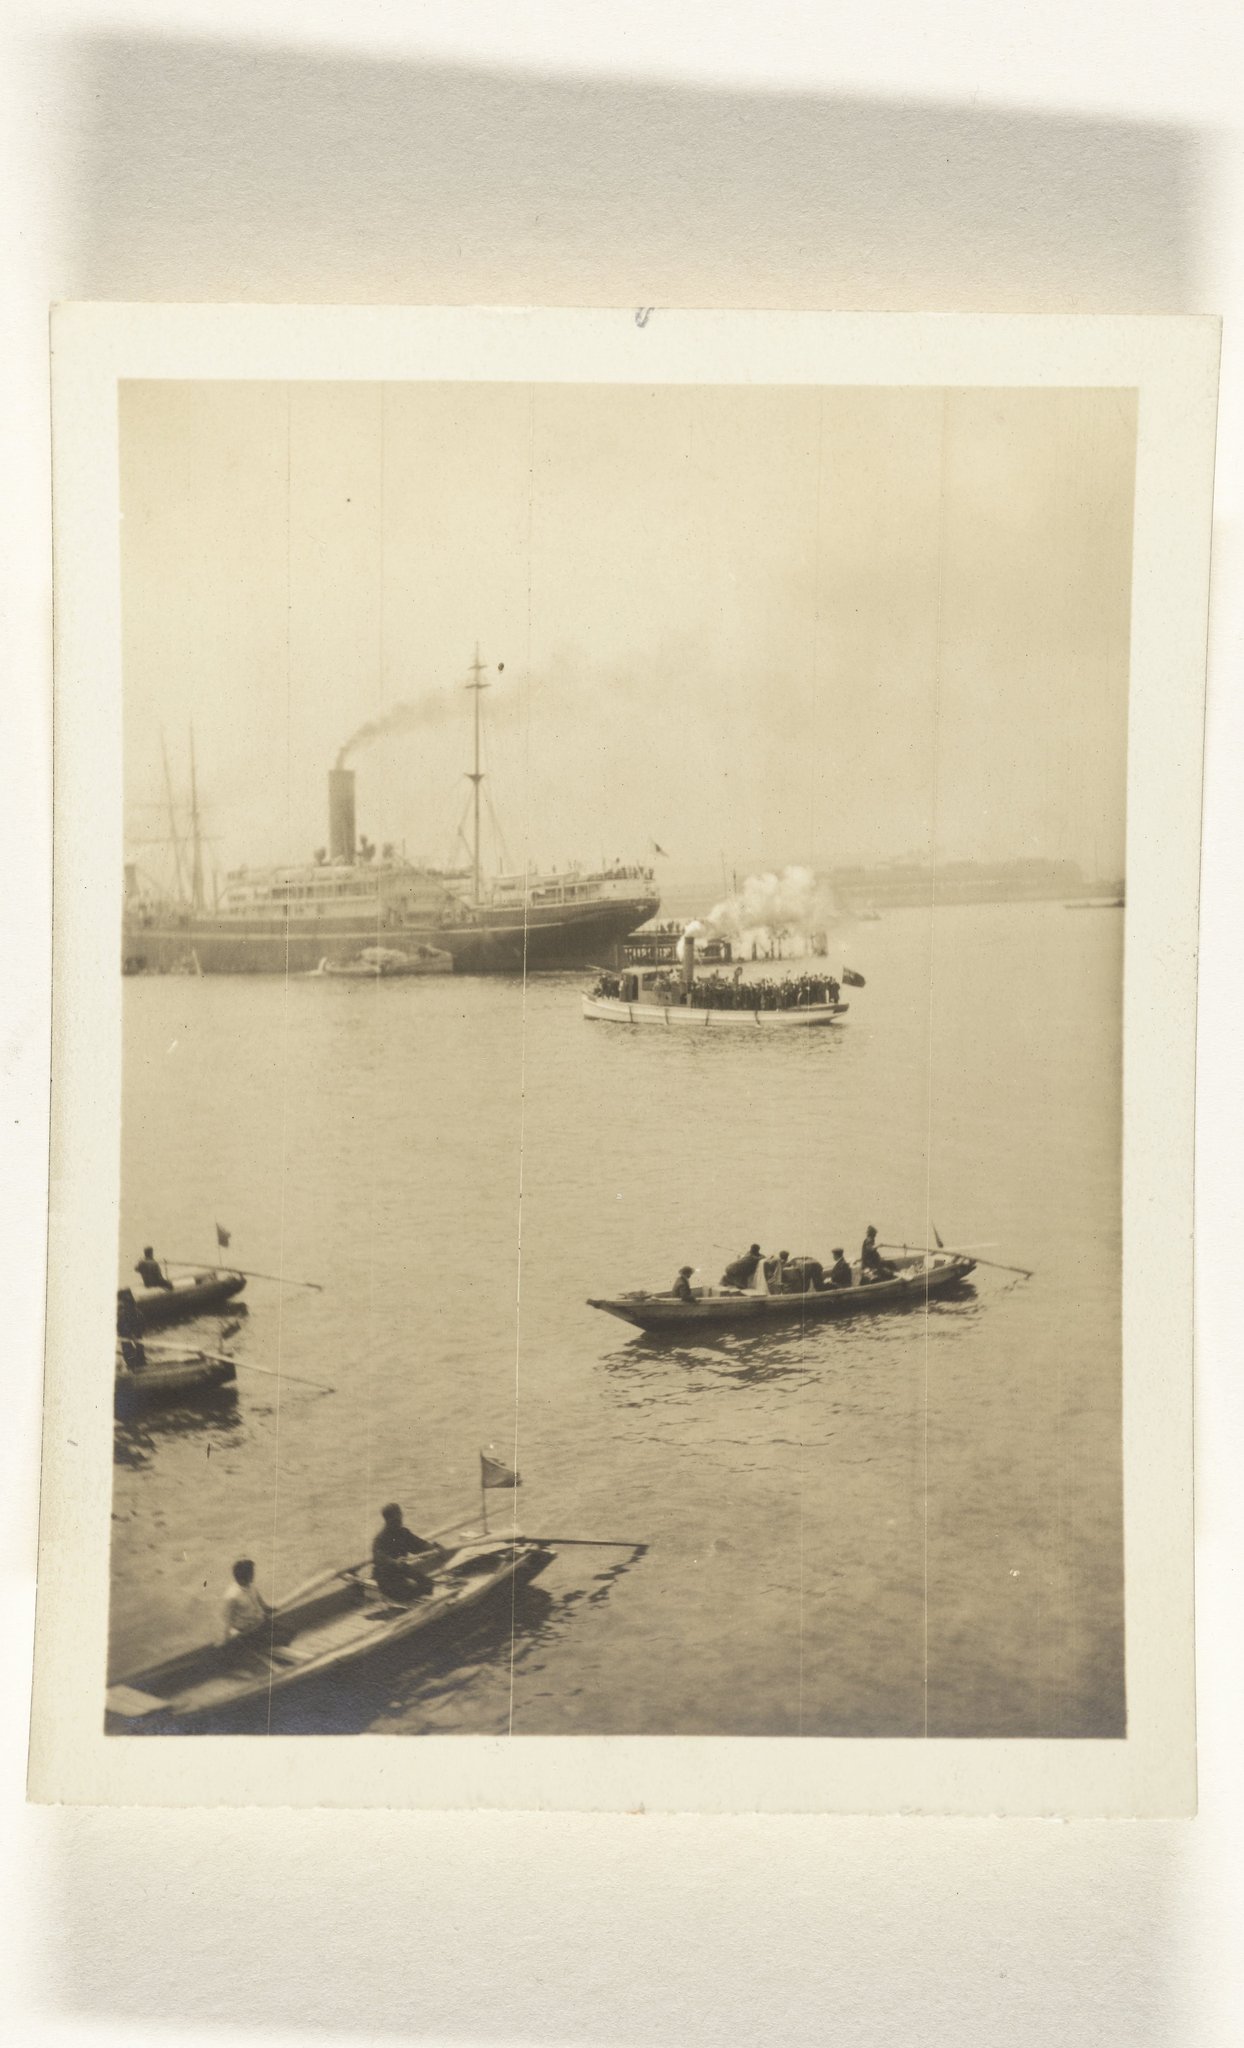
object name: photograph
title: Whistling and waving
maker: geldolph adriaan kessler (dolph)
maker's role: fotograaf, industrieel, voetballer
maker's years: 1884-1945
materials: cardboard, photographic support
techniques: gelatin silver print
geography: vancouver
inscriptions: title: ‘Whistling and waving’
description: Het vertrek vanaf the Empress of India voor de kust van Vancouver. Onderdeel van het fotoalbum van Dolph Kessler met opnamen die hij maakte tijdens zijn verblijf in Engeland en op een wereldreis die hij als secretaris van Henri Deterding (directeur Koninklijke Olie) ondernam naar Nederlands-Indië, Japan, China en de Verenigde Staten, tussen 1906 en 1908.